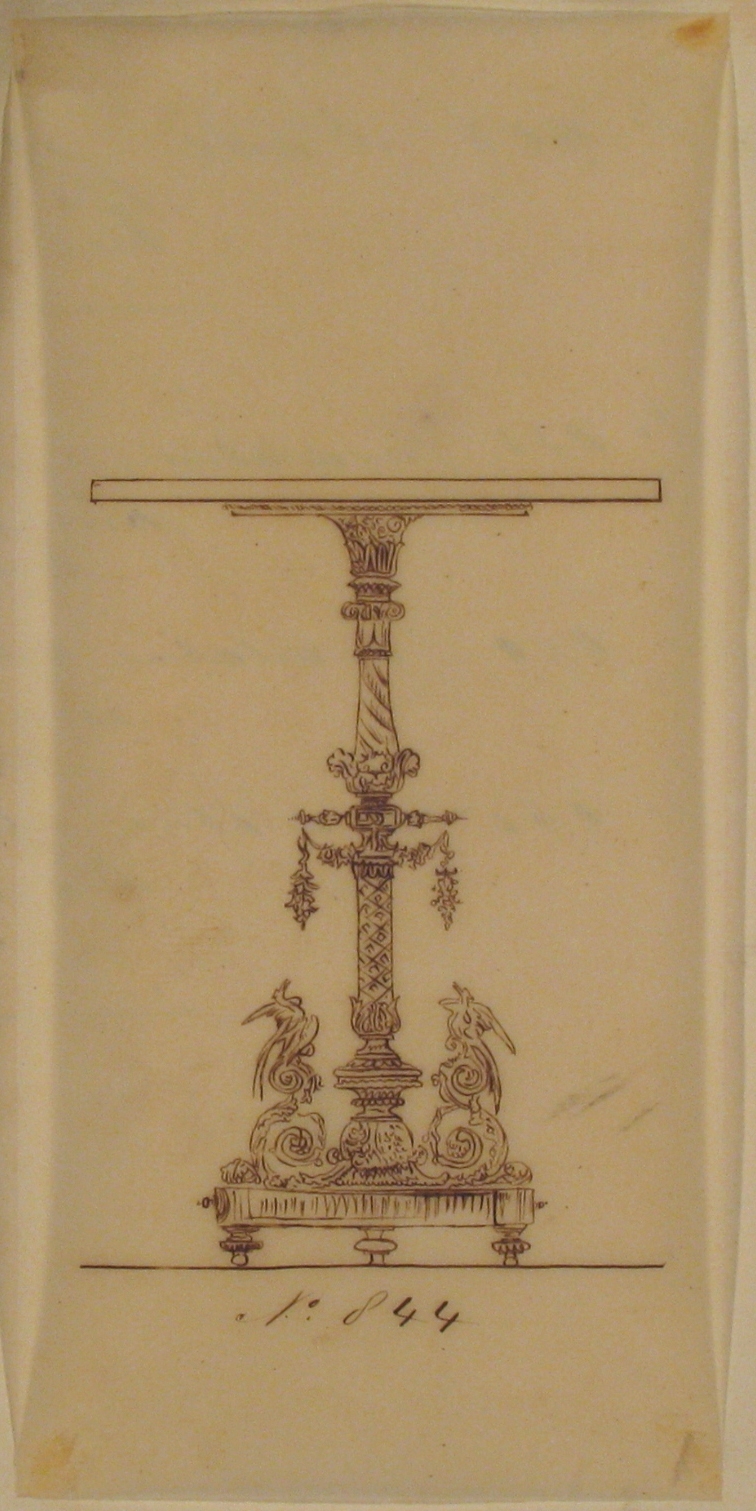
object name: drawing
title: Design for a Table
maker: anonymous, french, 19th century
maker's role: artist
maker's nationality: french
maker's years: 1800-1900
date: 1801-1900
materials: ink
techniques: pen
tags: tables